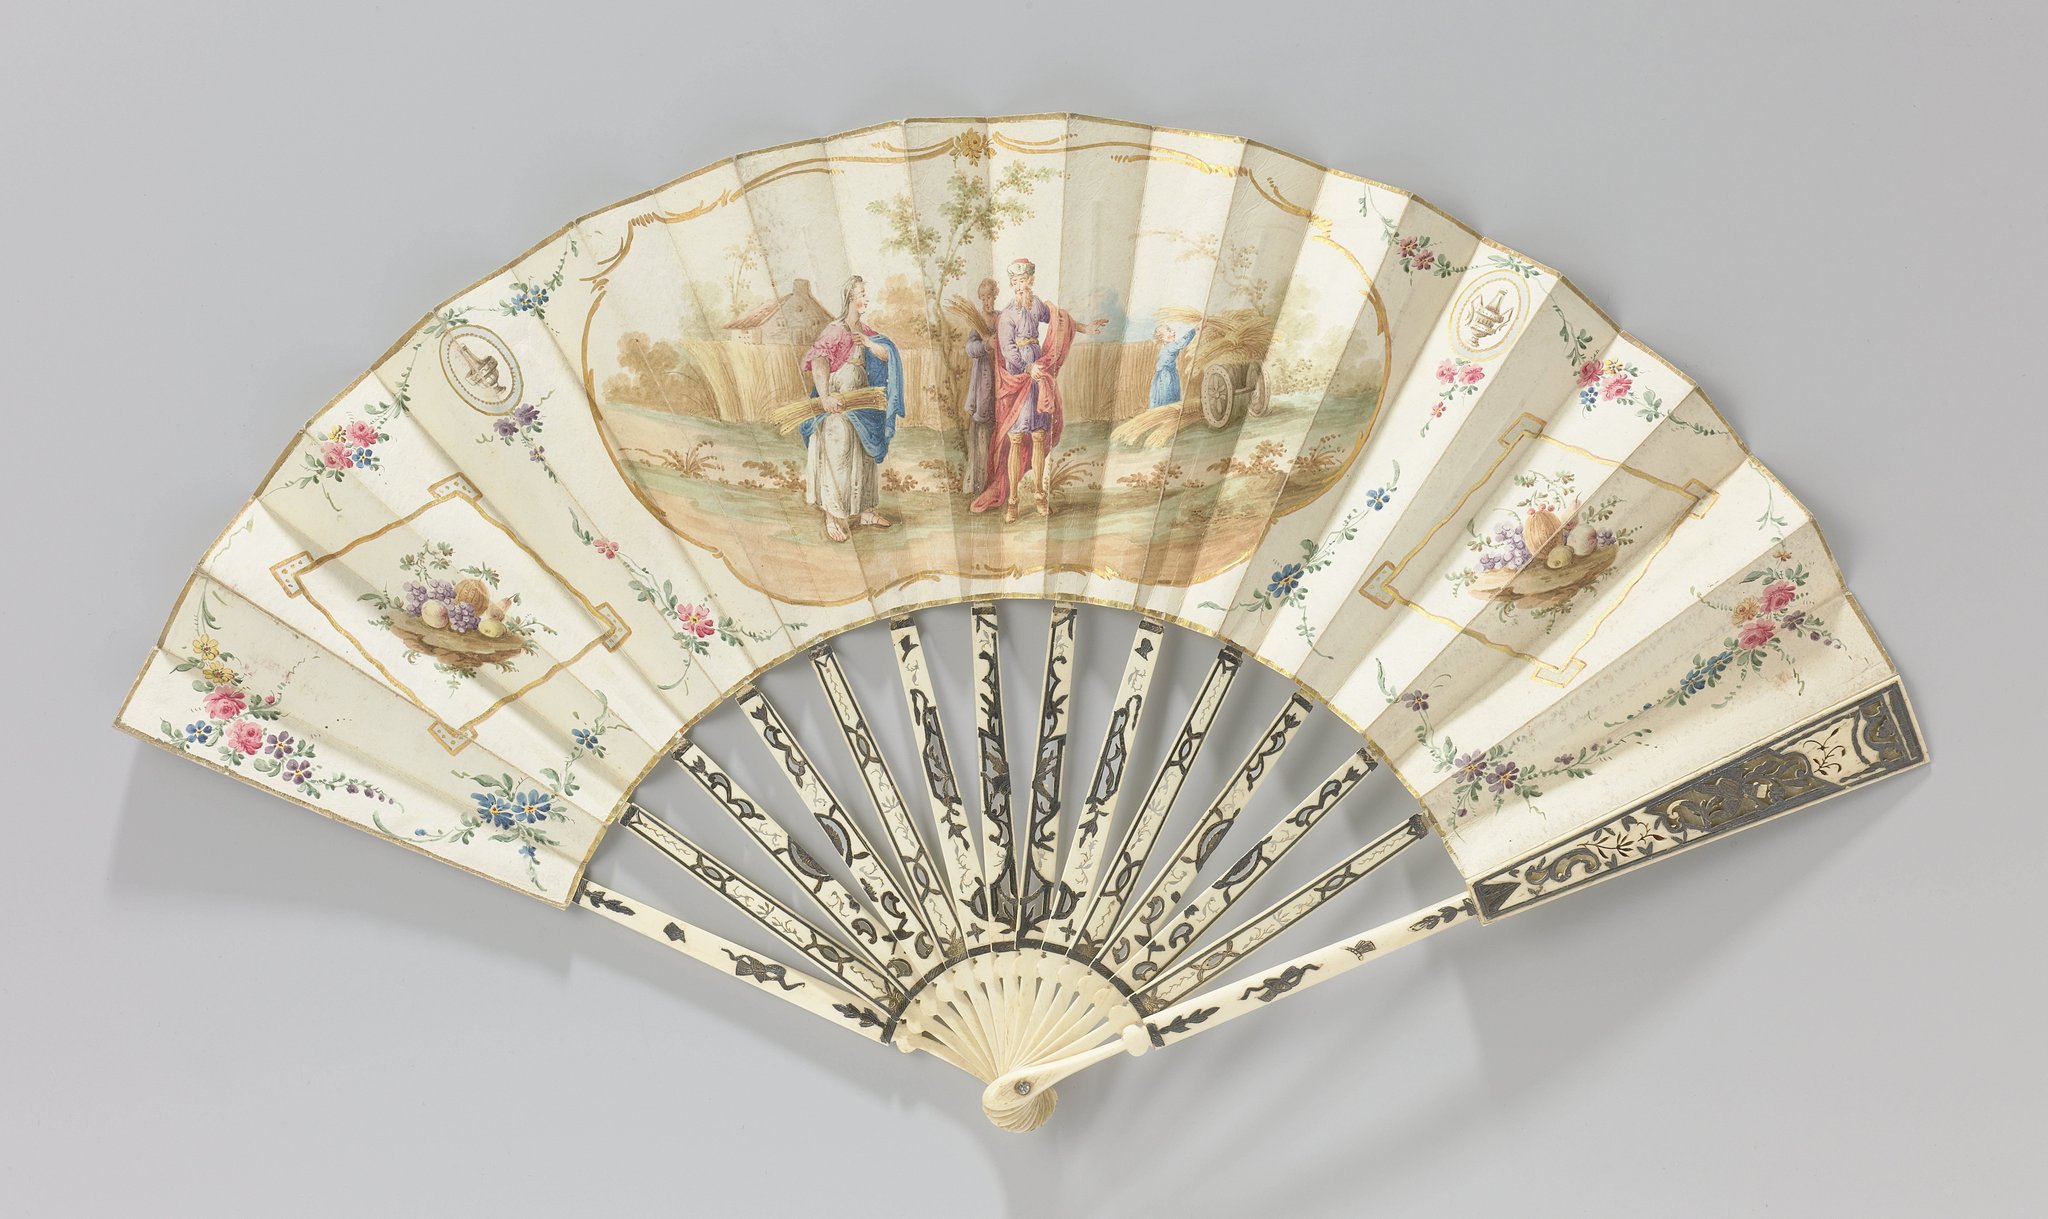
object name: vouwwaaier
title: Vouwwaaier met voorstelling van de ontmoeting tussen Ruth en Boas tijdens de korenoogst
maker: Anonymous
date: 1780-1795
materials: bone, gold, paint, paper, paste, silver leaf, watercolor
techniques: aquarelle, cutting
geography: netherlands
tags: johanna catharina adelaïde barones snouckaert van schauburg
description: Vouwwaaier met blad van papier waarop met aquarel en goudverf centraal een voorstelling van de ontmoeting tussen Ruth en Boas tijdens de korenoogst, geflankeerd door cartouches met vruchten, op een open montuur van gesneden been ingelegd met bladzilver en goud. In de centrale, goudomrande cartouche kijkt Ruth verbaasd naar Boas, de eigenaar van het korenveld, die haar 'betrapt' bij het oogsten. Op het tweede plan staat een andere vrouw en rechts achter stapelt een jongen korenschoven op een kar. Dit wordt geflankeerd door kleine ovale medaillons waarin een klassieke vaas en grotere ruiten gevuld met druiven, appels, peren, perzikken en meloen. Het geheel is voorzien van bloemenslingers. Op de achterkant van het blad in het midden een blad- en bloemmotief. Het montuur met veertien benen heeft een centrale cartouche met een pijlenkoker geflankeerd door medaillons met bloemen. Op de sluitbenen pijlenkokers, slingers en fantasiemotieven. Sluitpin van koper met stras.